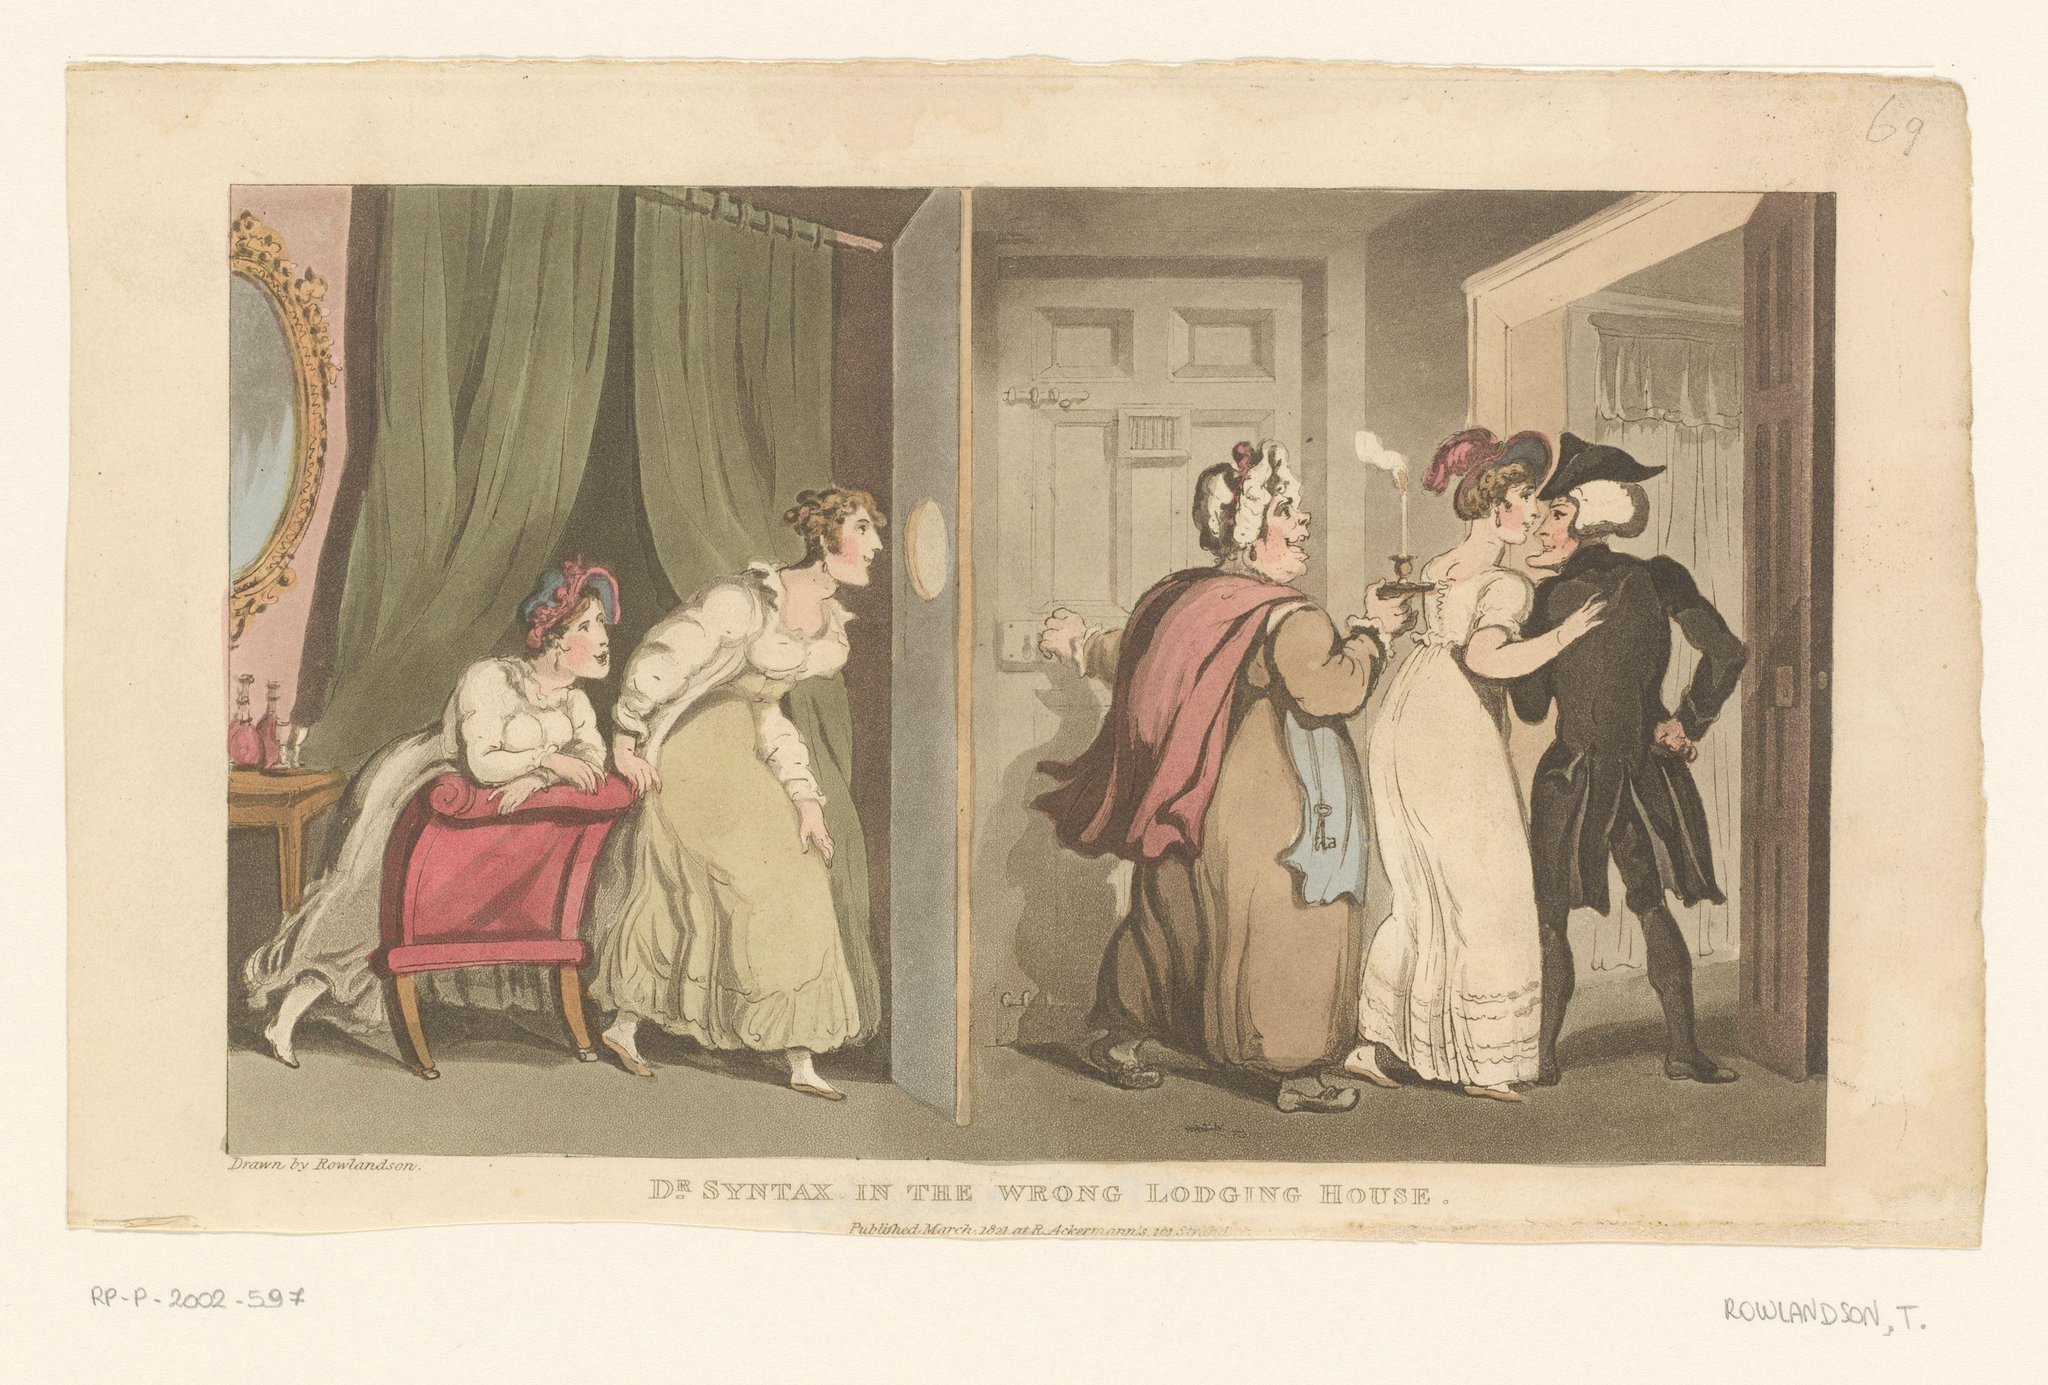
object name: print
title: Dr. Syntax in the wrong lodging house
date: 1803-1821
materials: paper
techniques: aquatint, etching, hand coloring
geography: london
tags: brothel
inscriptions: collector's mark: Lugt 2228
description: Prent ook gebruikt in: Combe, William. The Third Tour of Doctor Syntax, in Search of a Wife: A Poem. Londen: Rudolph Ackermann, 1821.